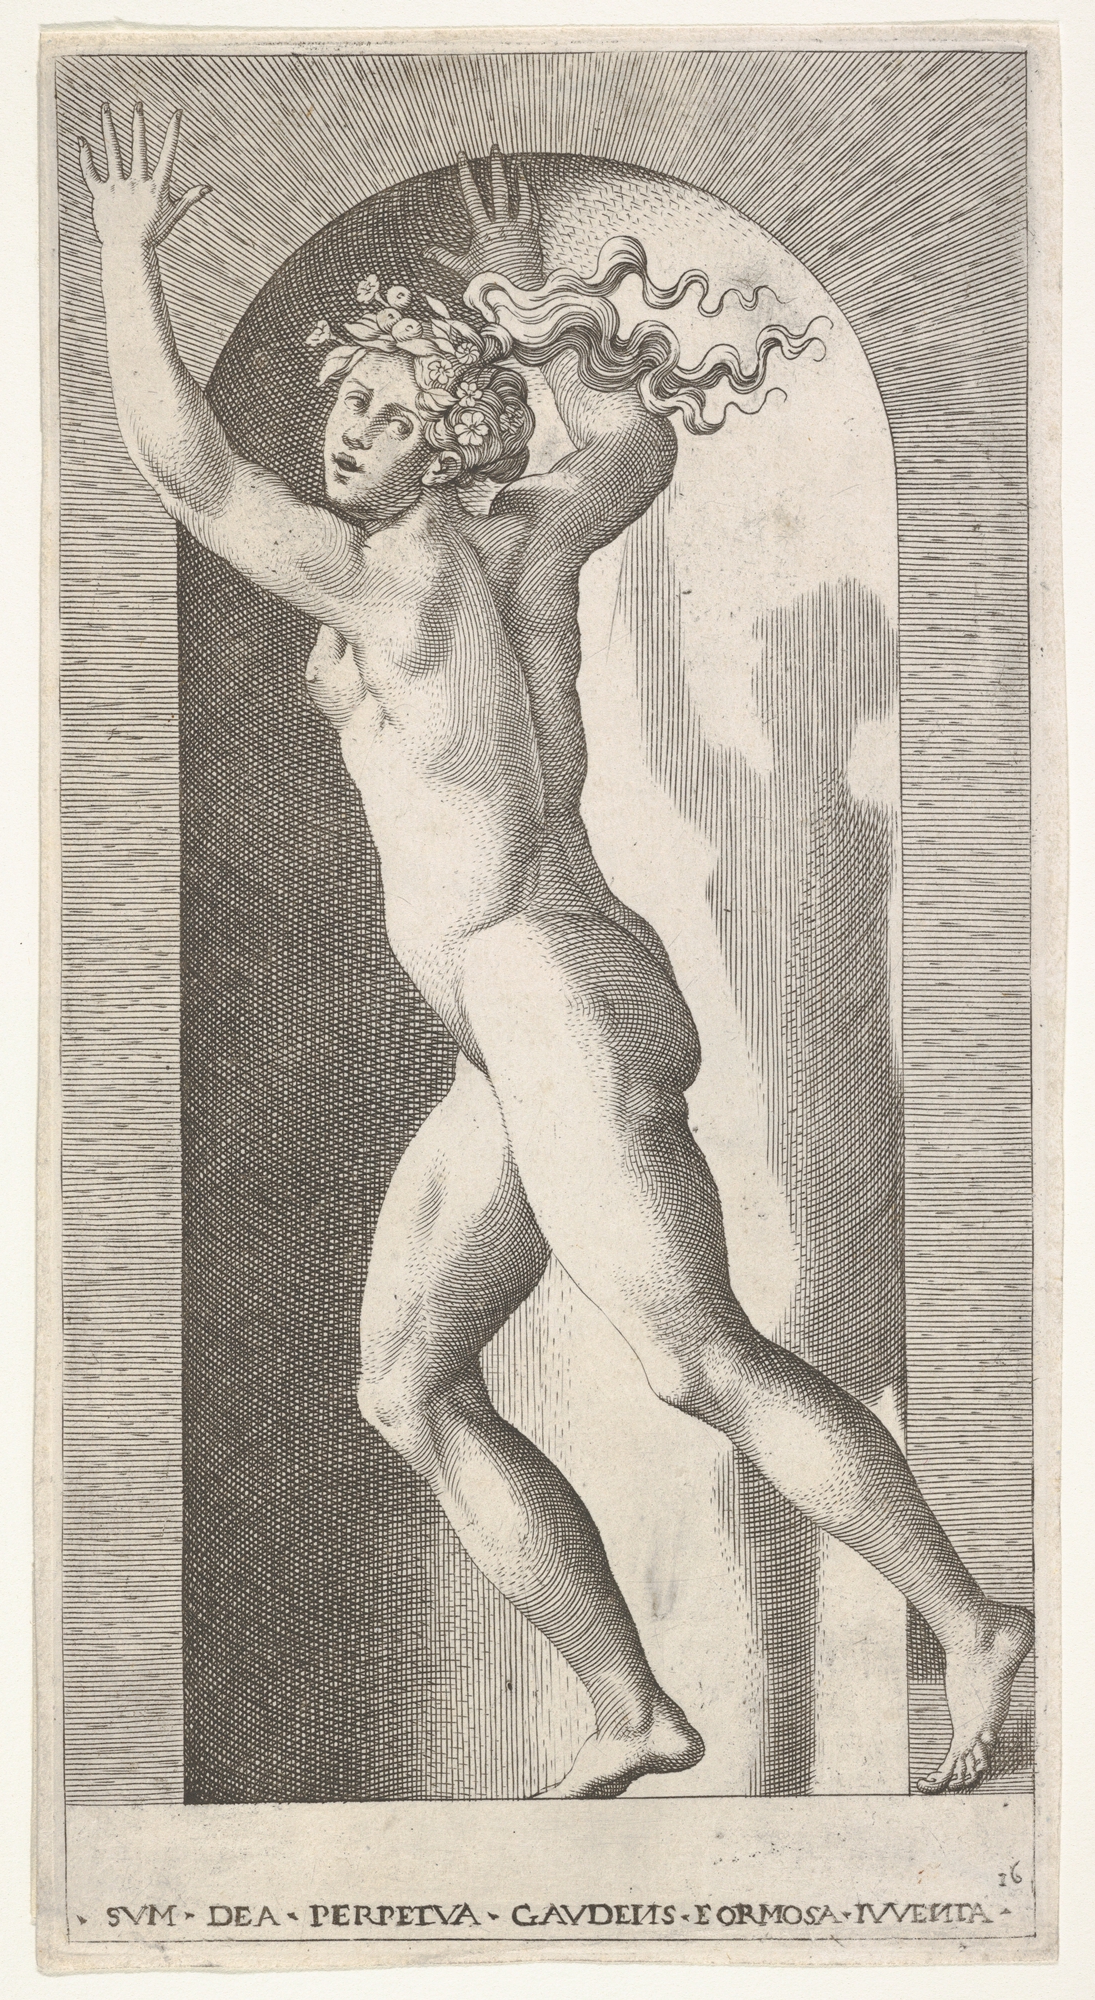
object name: print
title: Plate 16: Hebe in a niche with her hands in the air, running to the left while looking to the right, from a series of mythological gods and goddesses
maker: giovanni jacopo caraglio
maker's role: artist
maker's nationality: italian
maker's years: 1500-1565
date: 1526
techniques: engraving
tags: female nudes